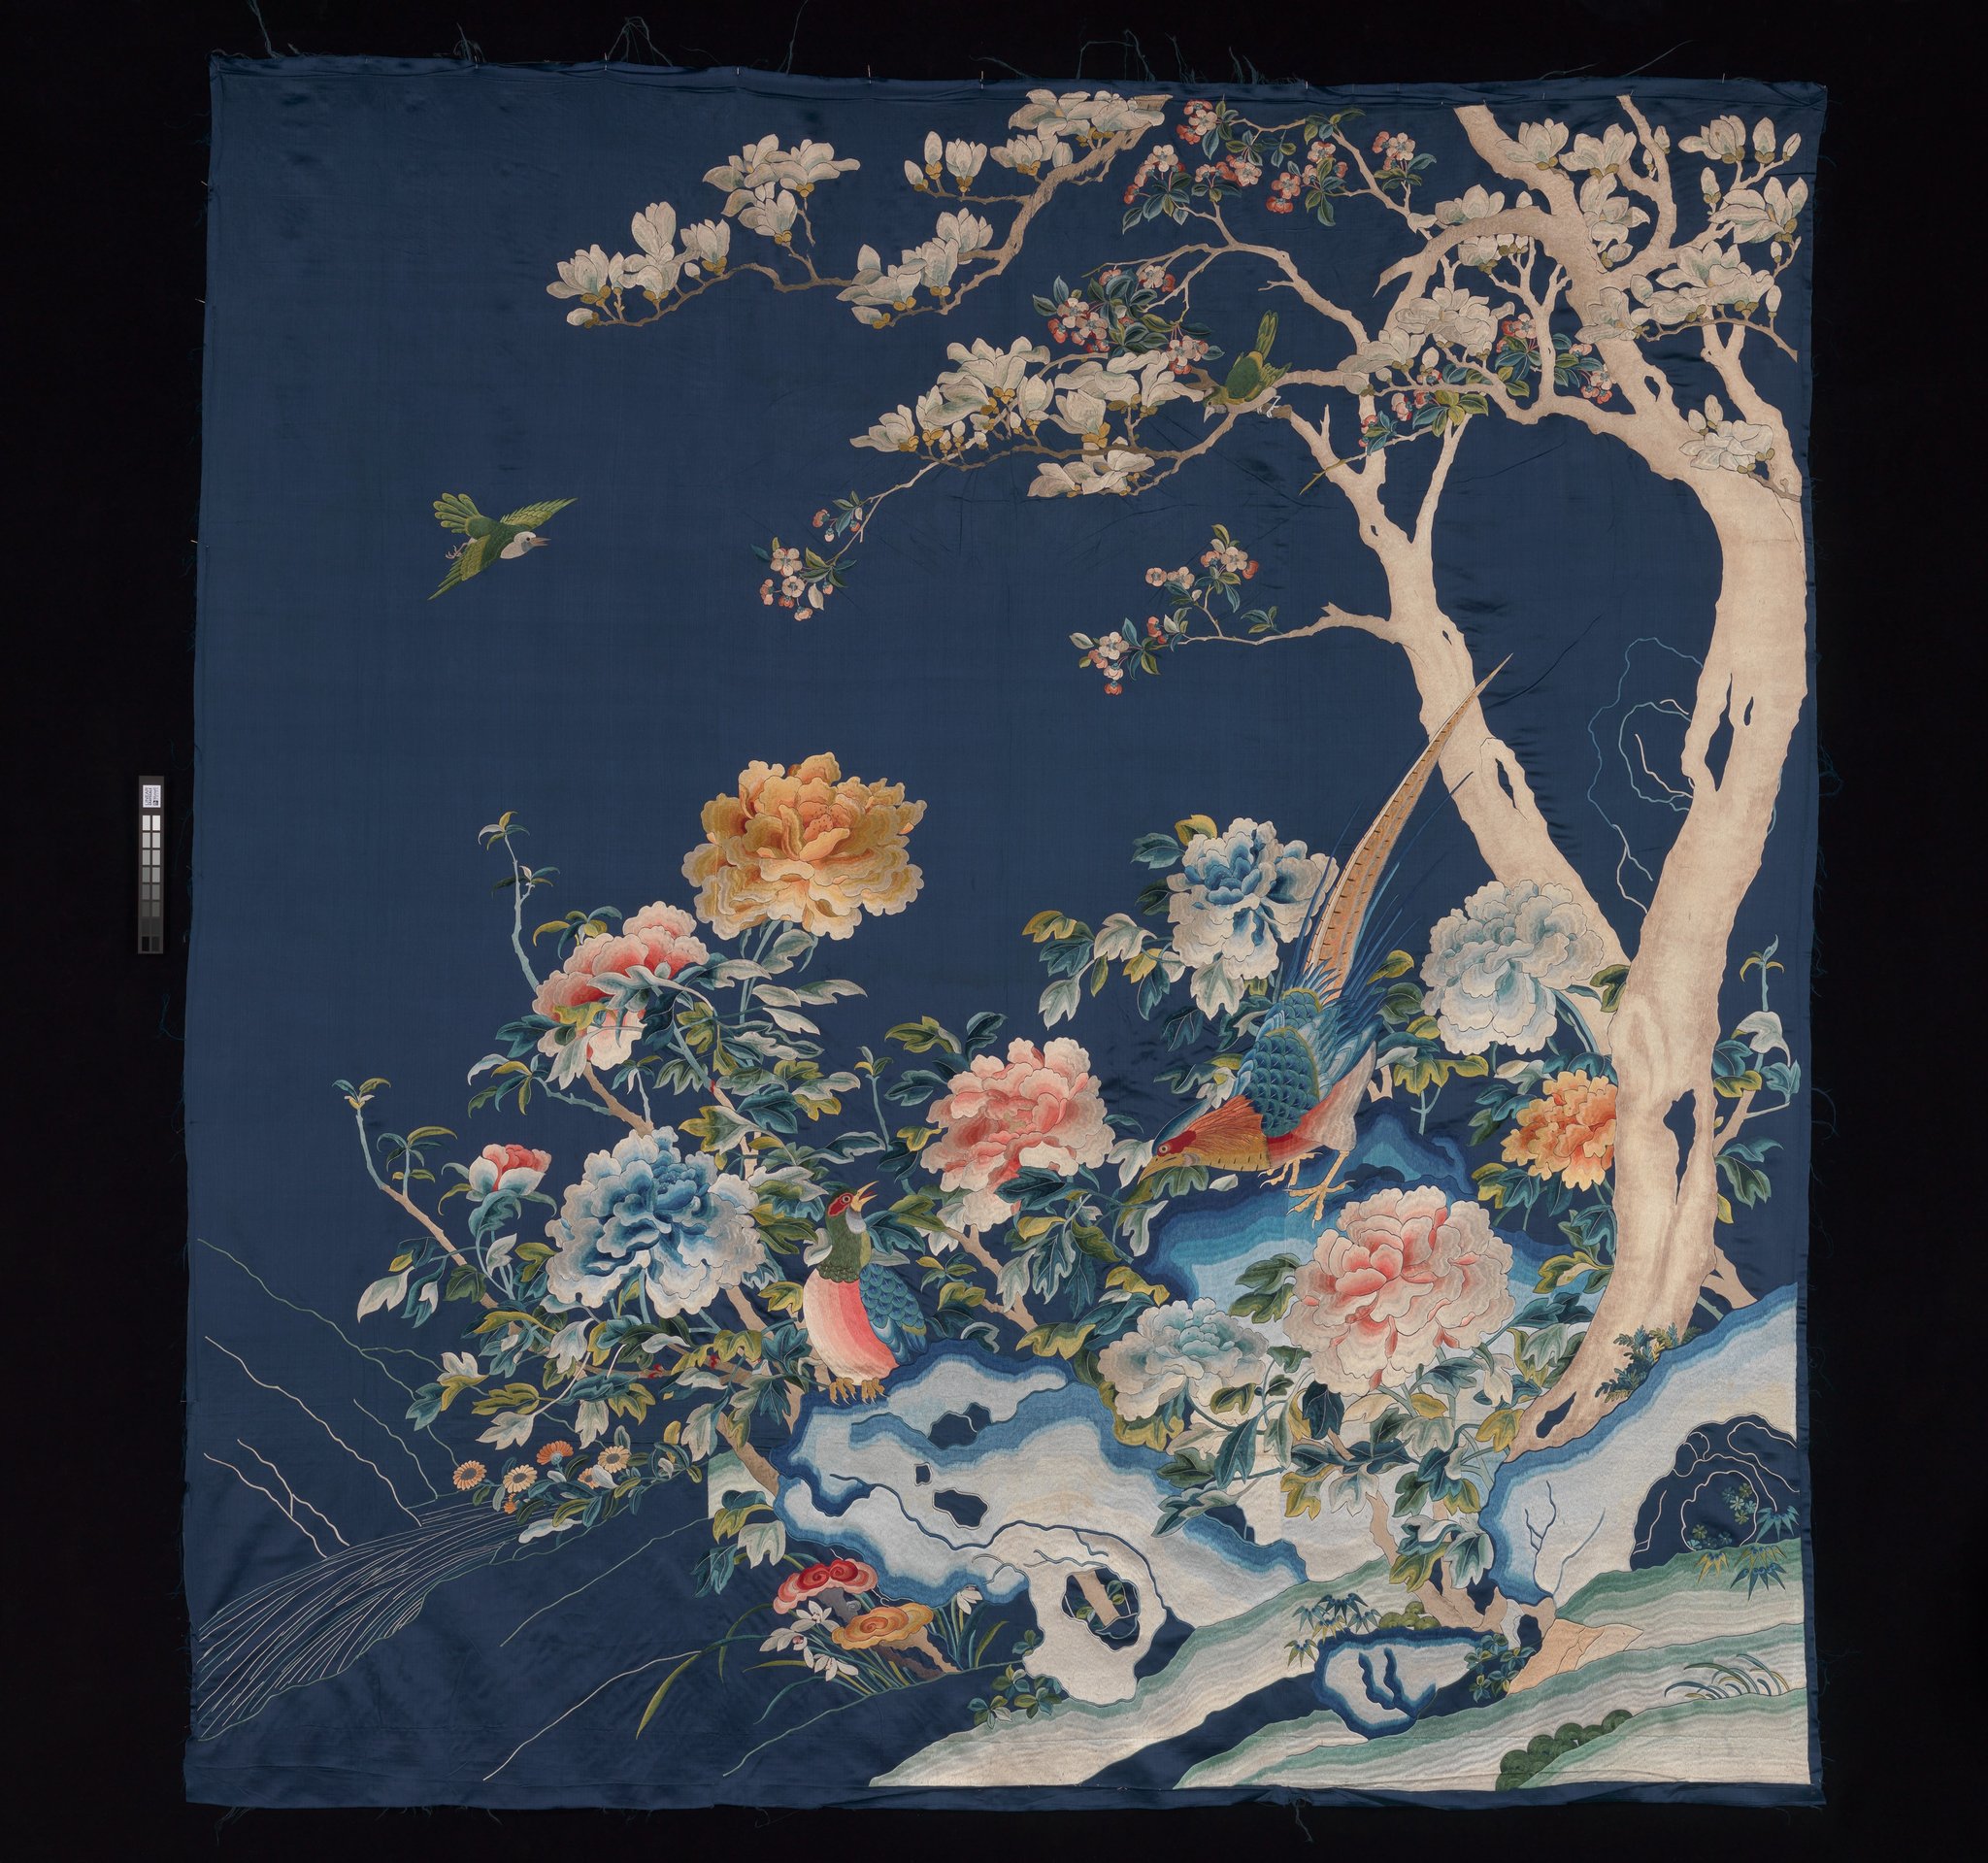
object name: hanging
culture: chinese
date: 1767-1833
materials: silk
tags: birds,flowers,leaves,trees